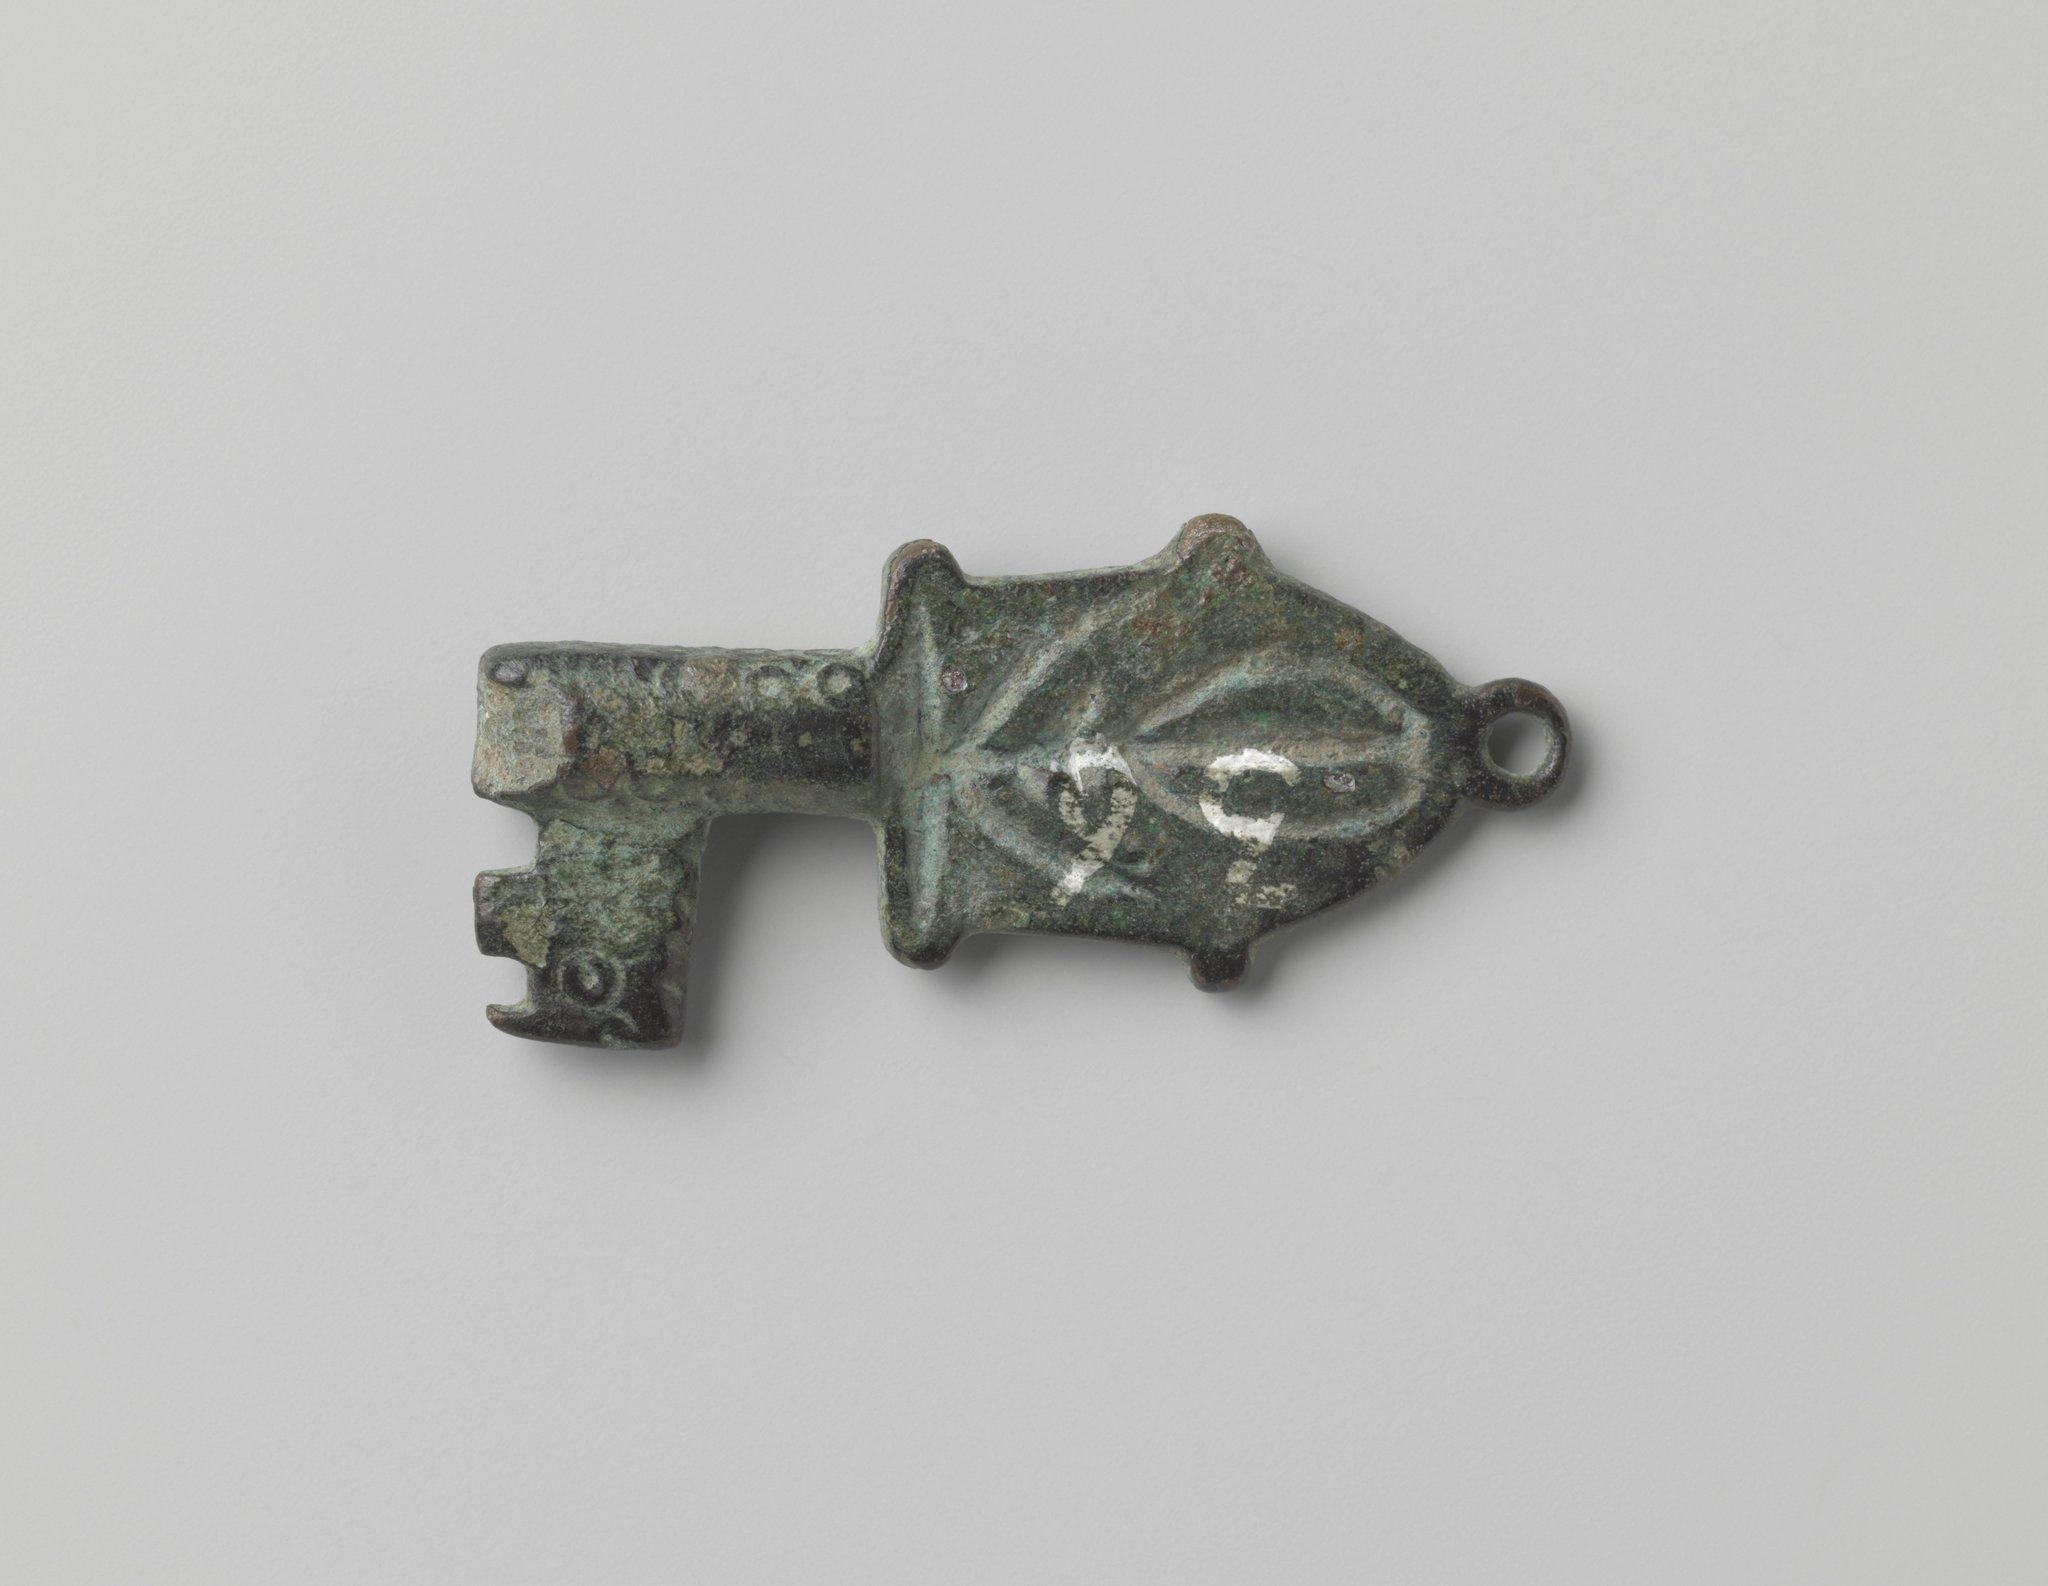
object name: key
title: Sleutel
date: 1400-1950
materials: bronze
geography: france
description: Sleutel met platte klokvormige greep, versierd met ingegroefde bladmotief en bekroond door een oog.